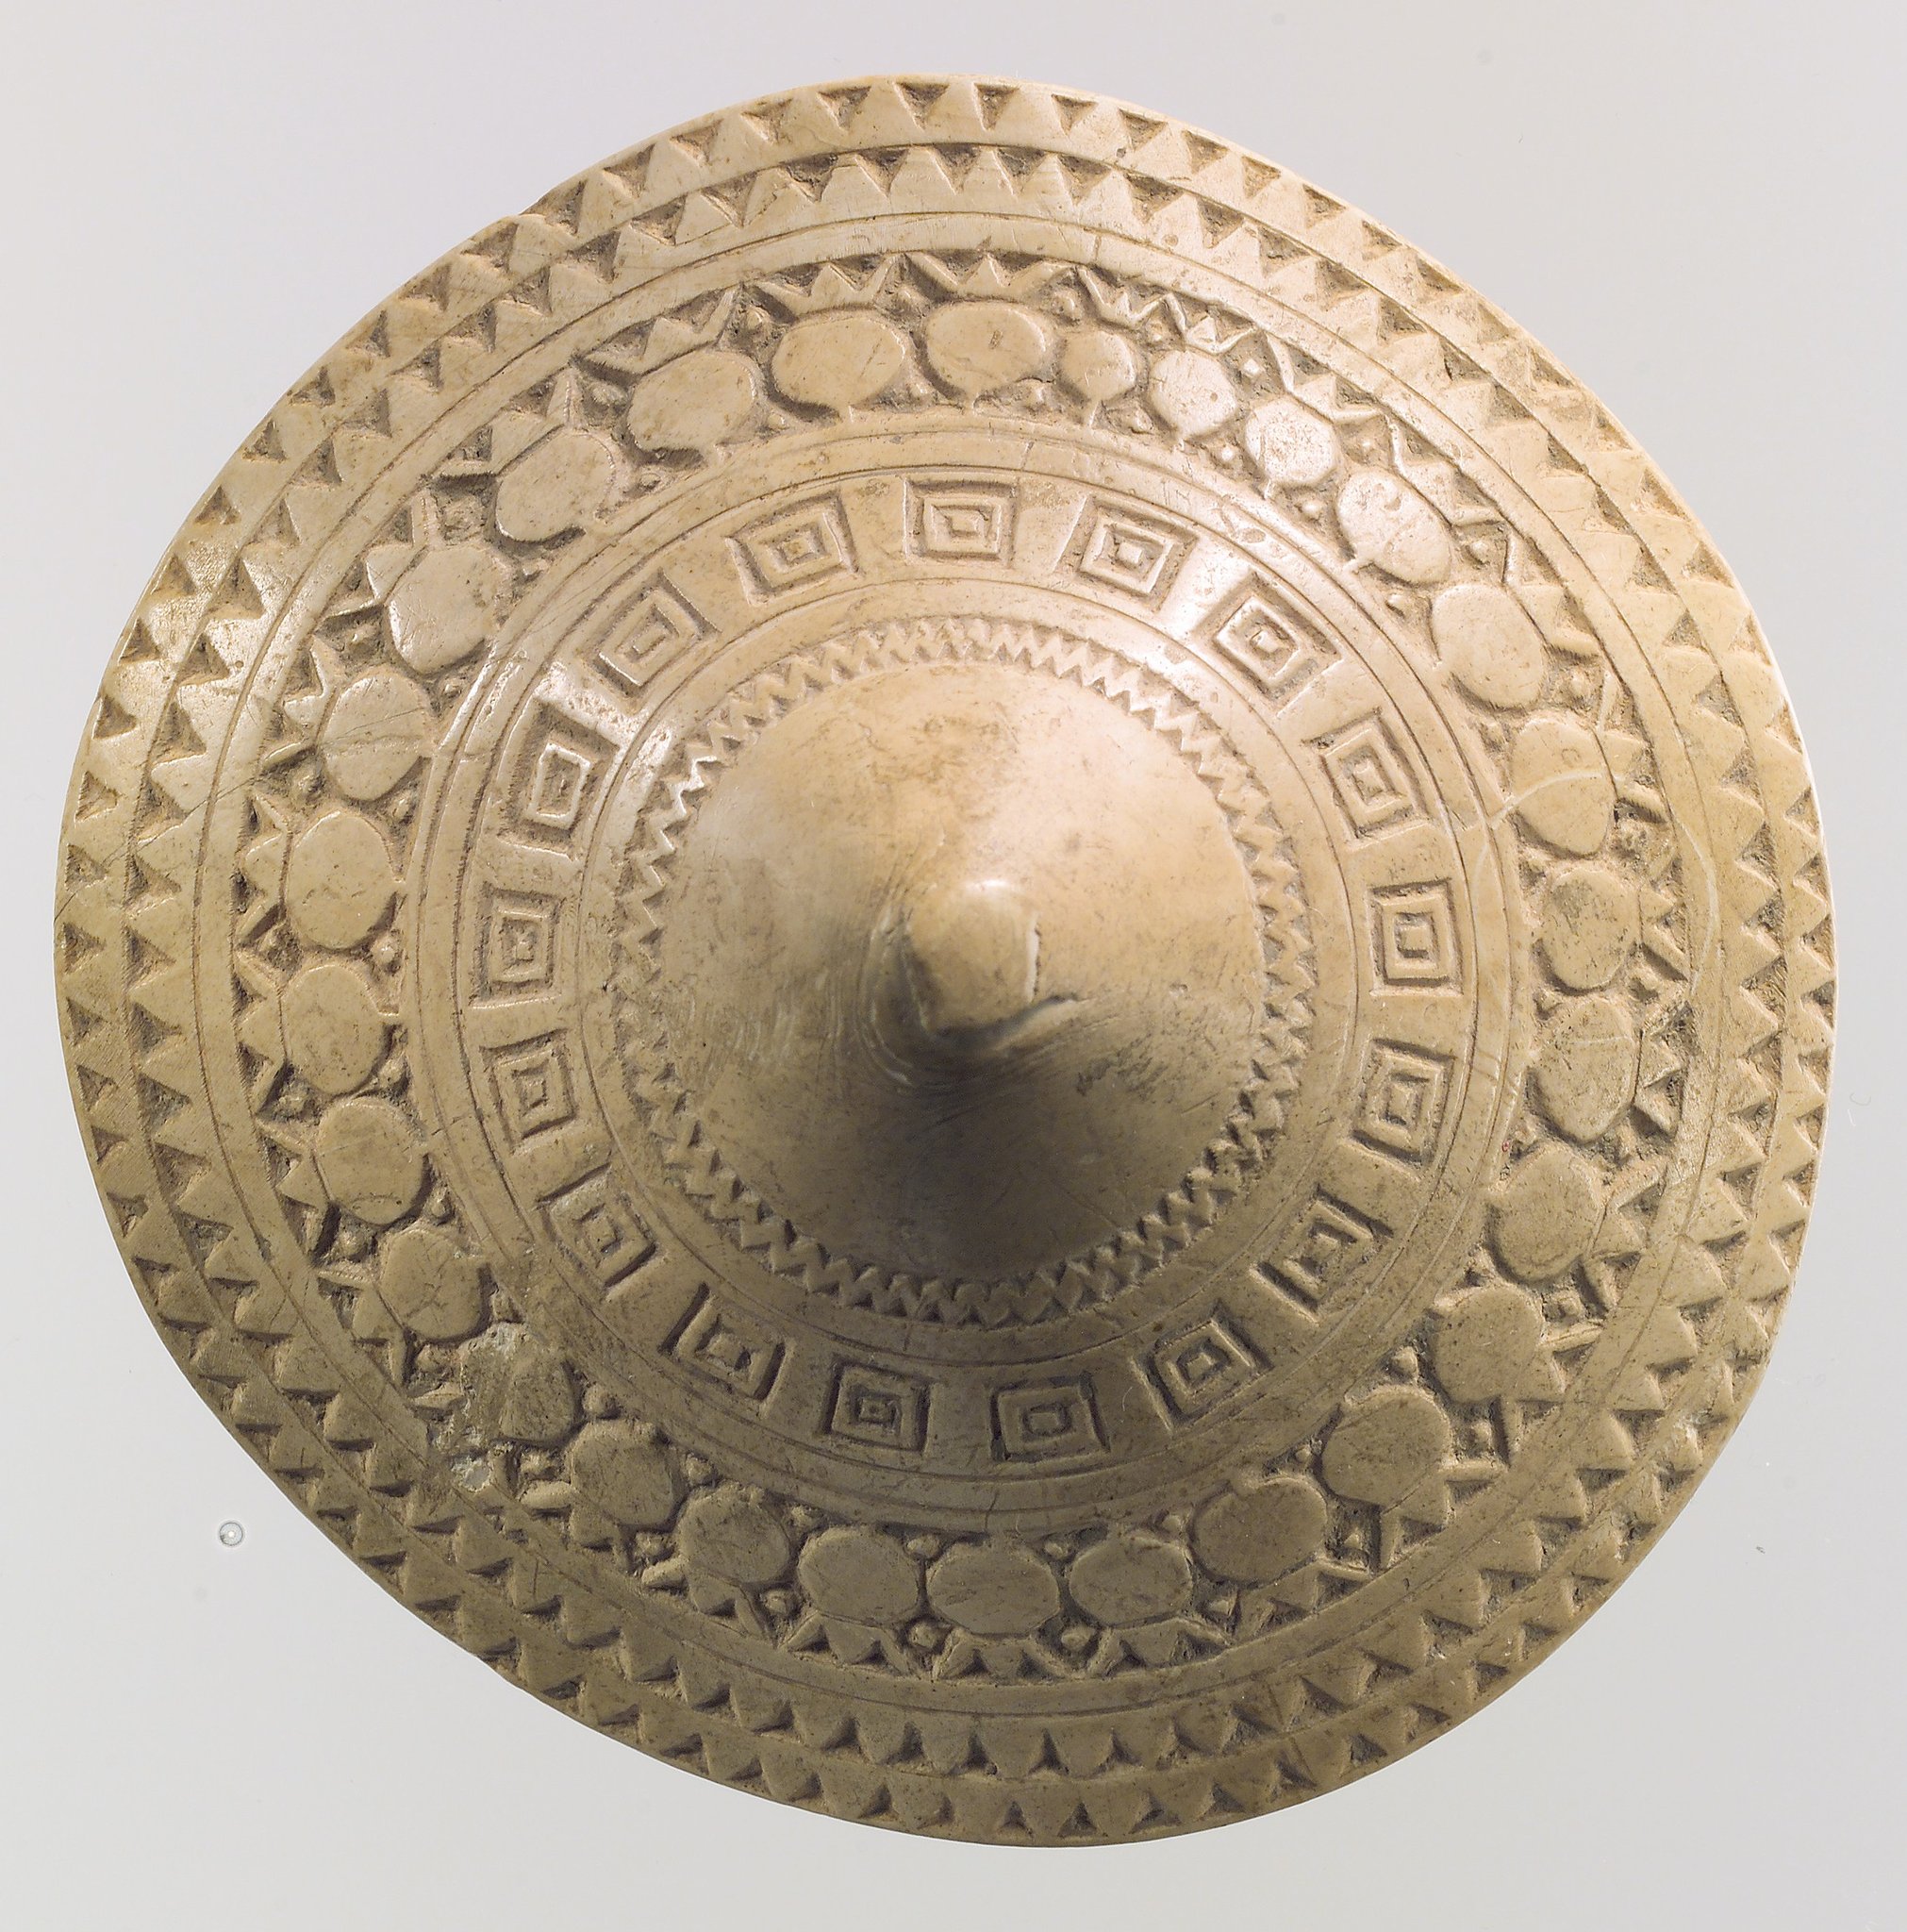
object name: bos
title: Boss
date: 800-701 BCE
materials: shell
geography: iran